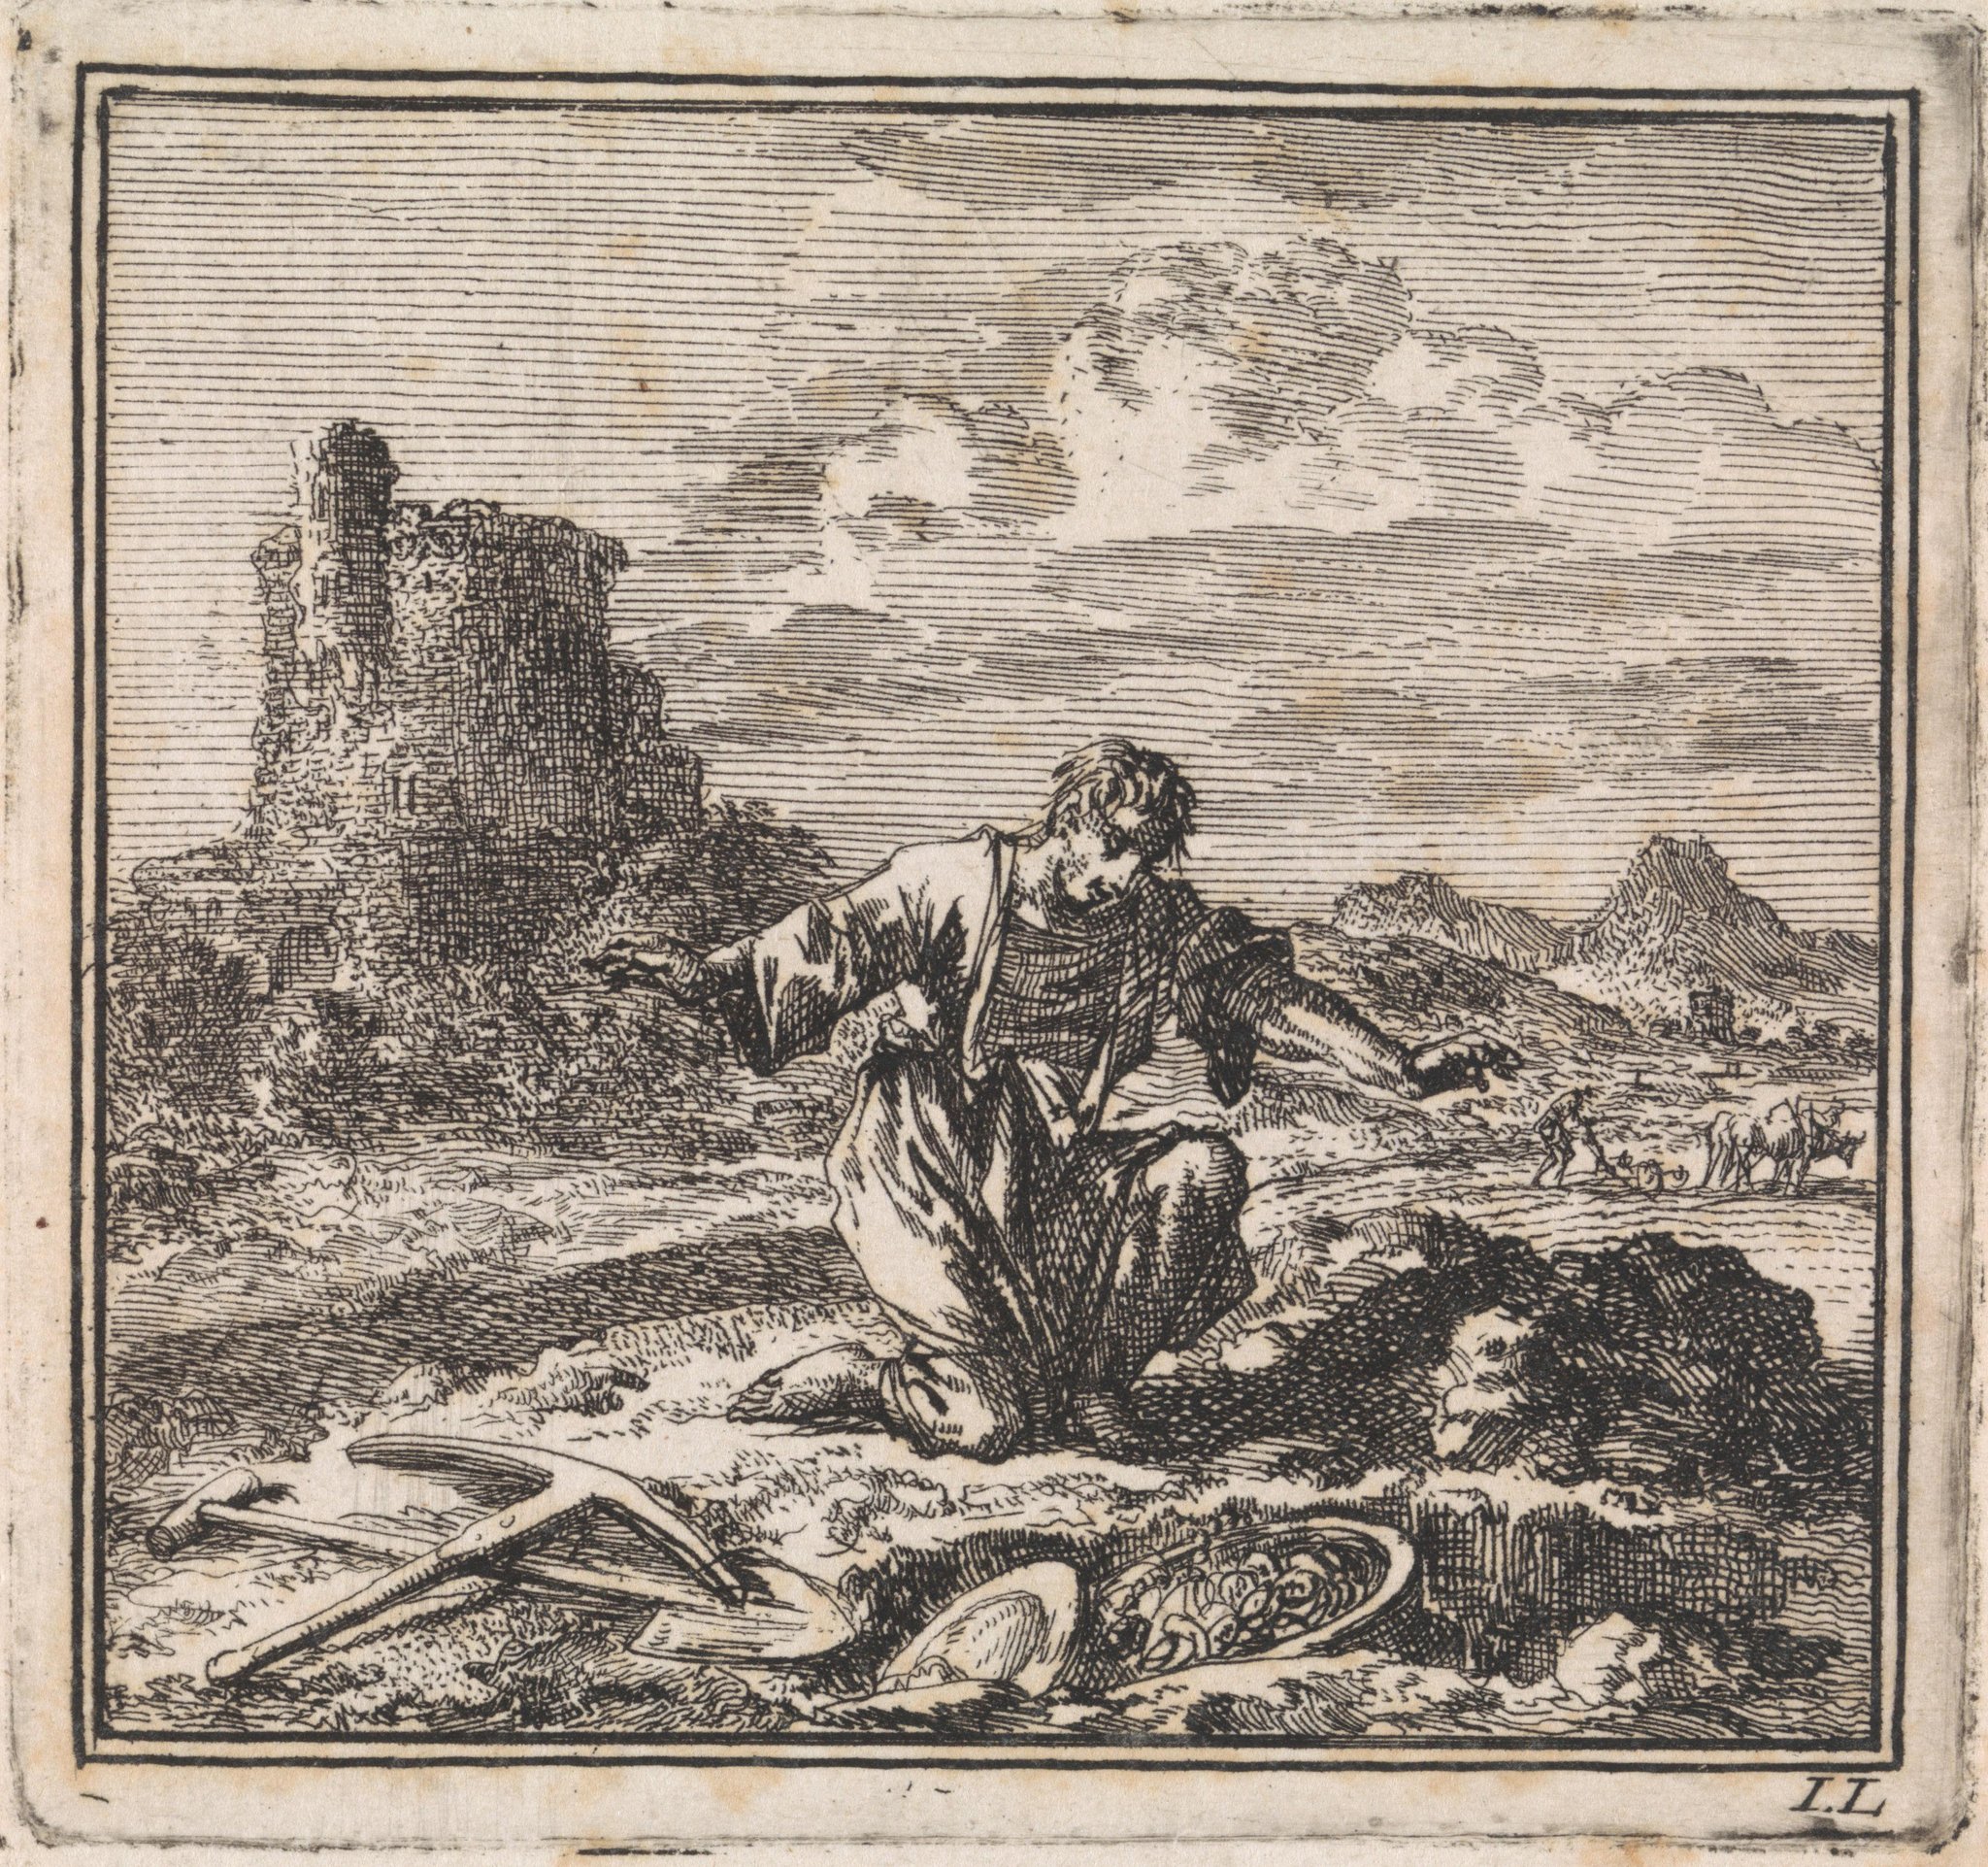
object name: book illustration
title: Man vindt een schat tijdens het werken op een akker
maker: jan luyken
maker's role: draughtsman, print maker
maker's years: 1649-1712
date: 1710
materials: paper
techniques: etching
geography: amsterdam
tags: treasure hunting, goldrush, landscapes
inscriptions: collector's mark: Lugt 2228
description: Illustratie uit: Luyken, Jan. De onwaardige wereld, vertoond in vyftig zinnebeelden, met godlyke spreuken en stichtelyke verzen. Amsterdam: Pieter Arentsz. II (wed.) en Cornelis van der Sys, 1710, p. 30.